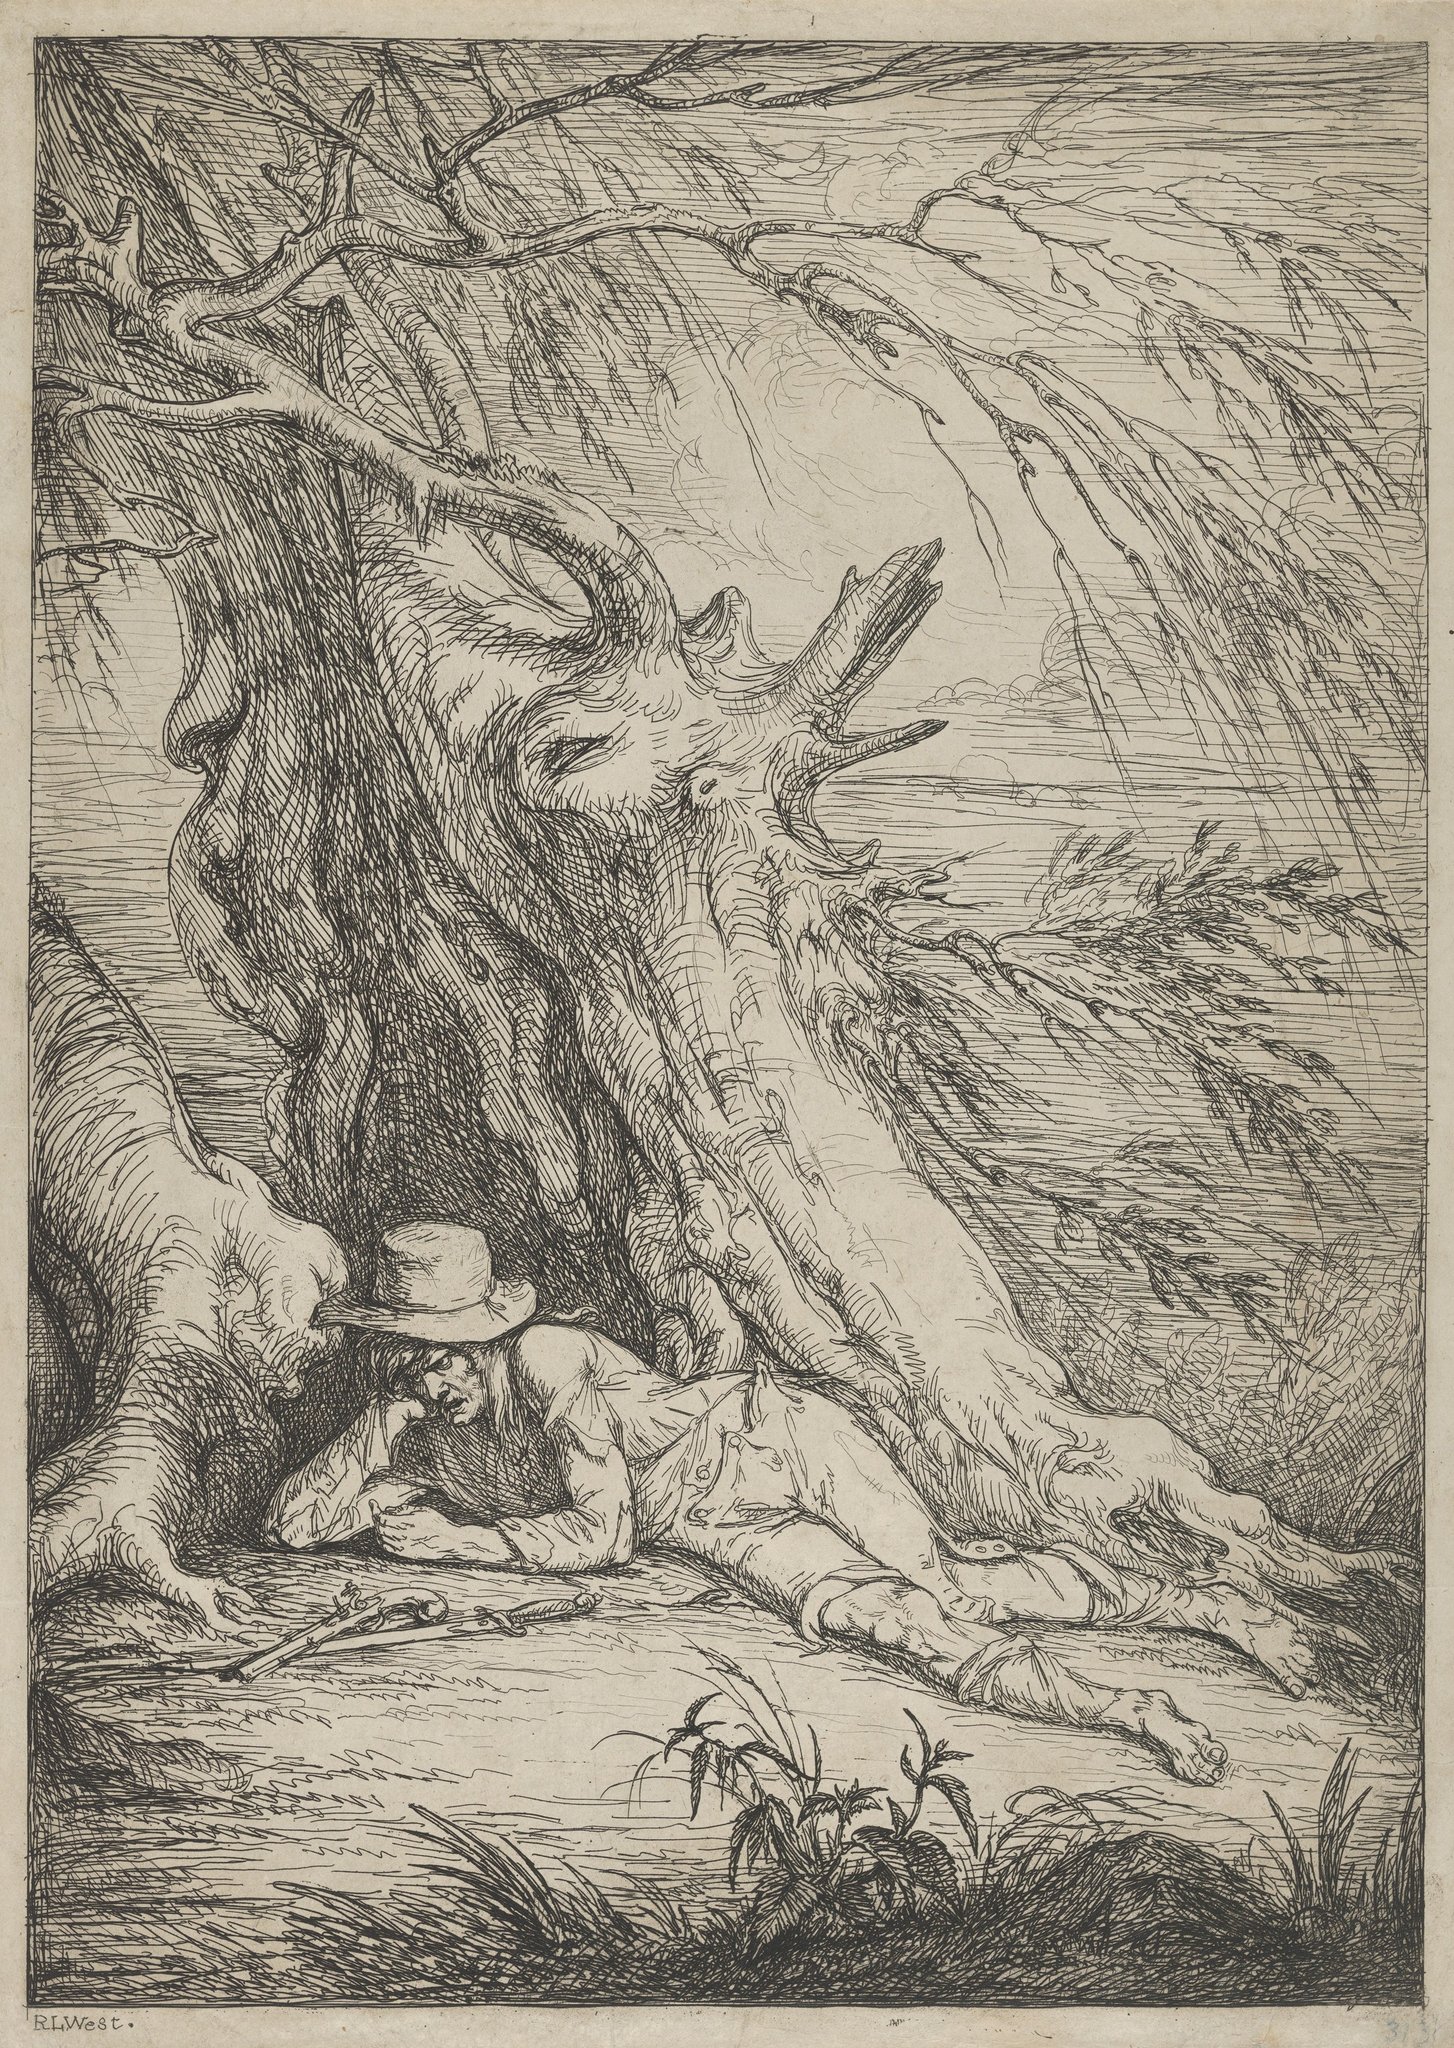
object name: print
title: Bandit Beneath a Tree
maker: raphael lamar west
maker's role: artist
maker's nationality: british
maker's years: 1769-1850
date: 1795-1801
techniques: etching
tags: weapons,men,trees